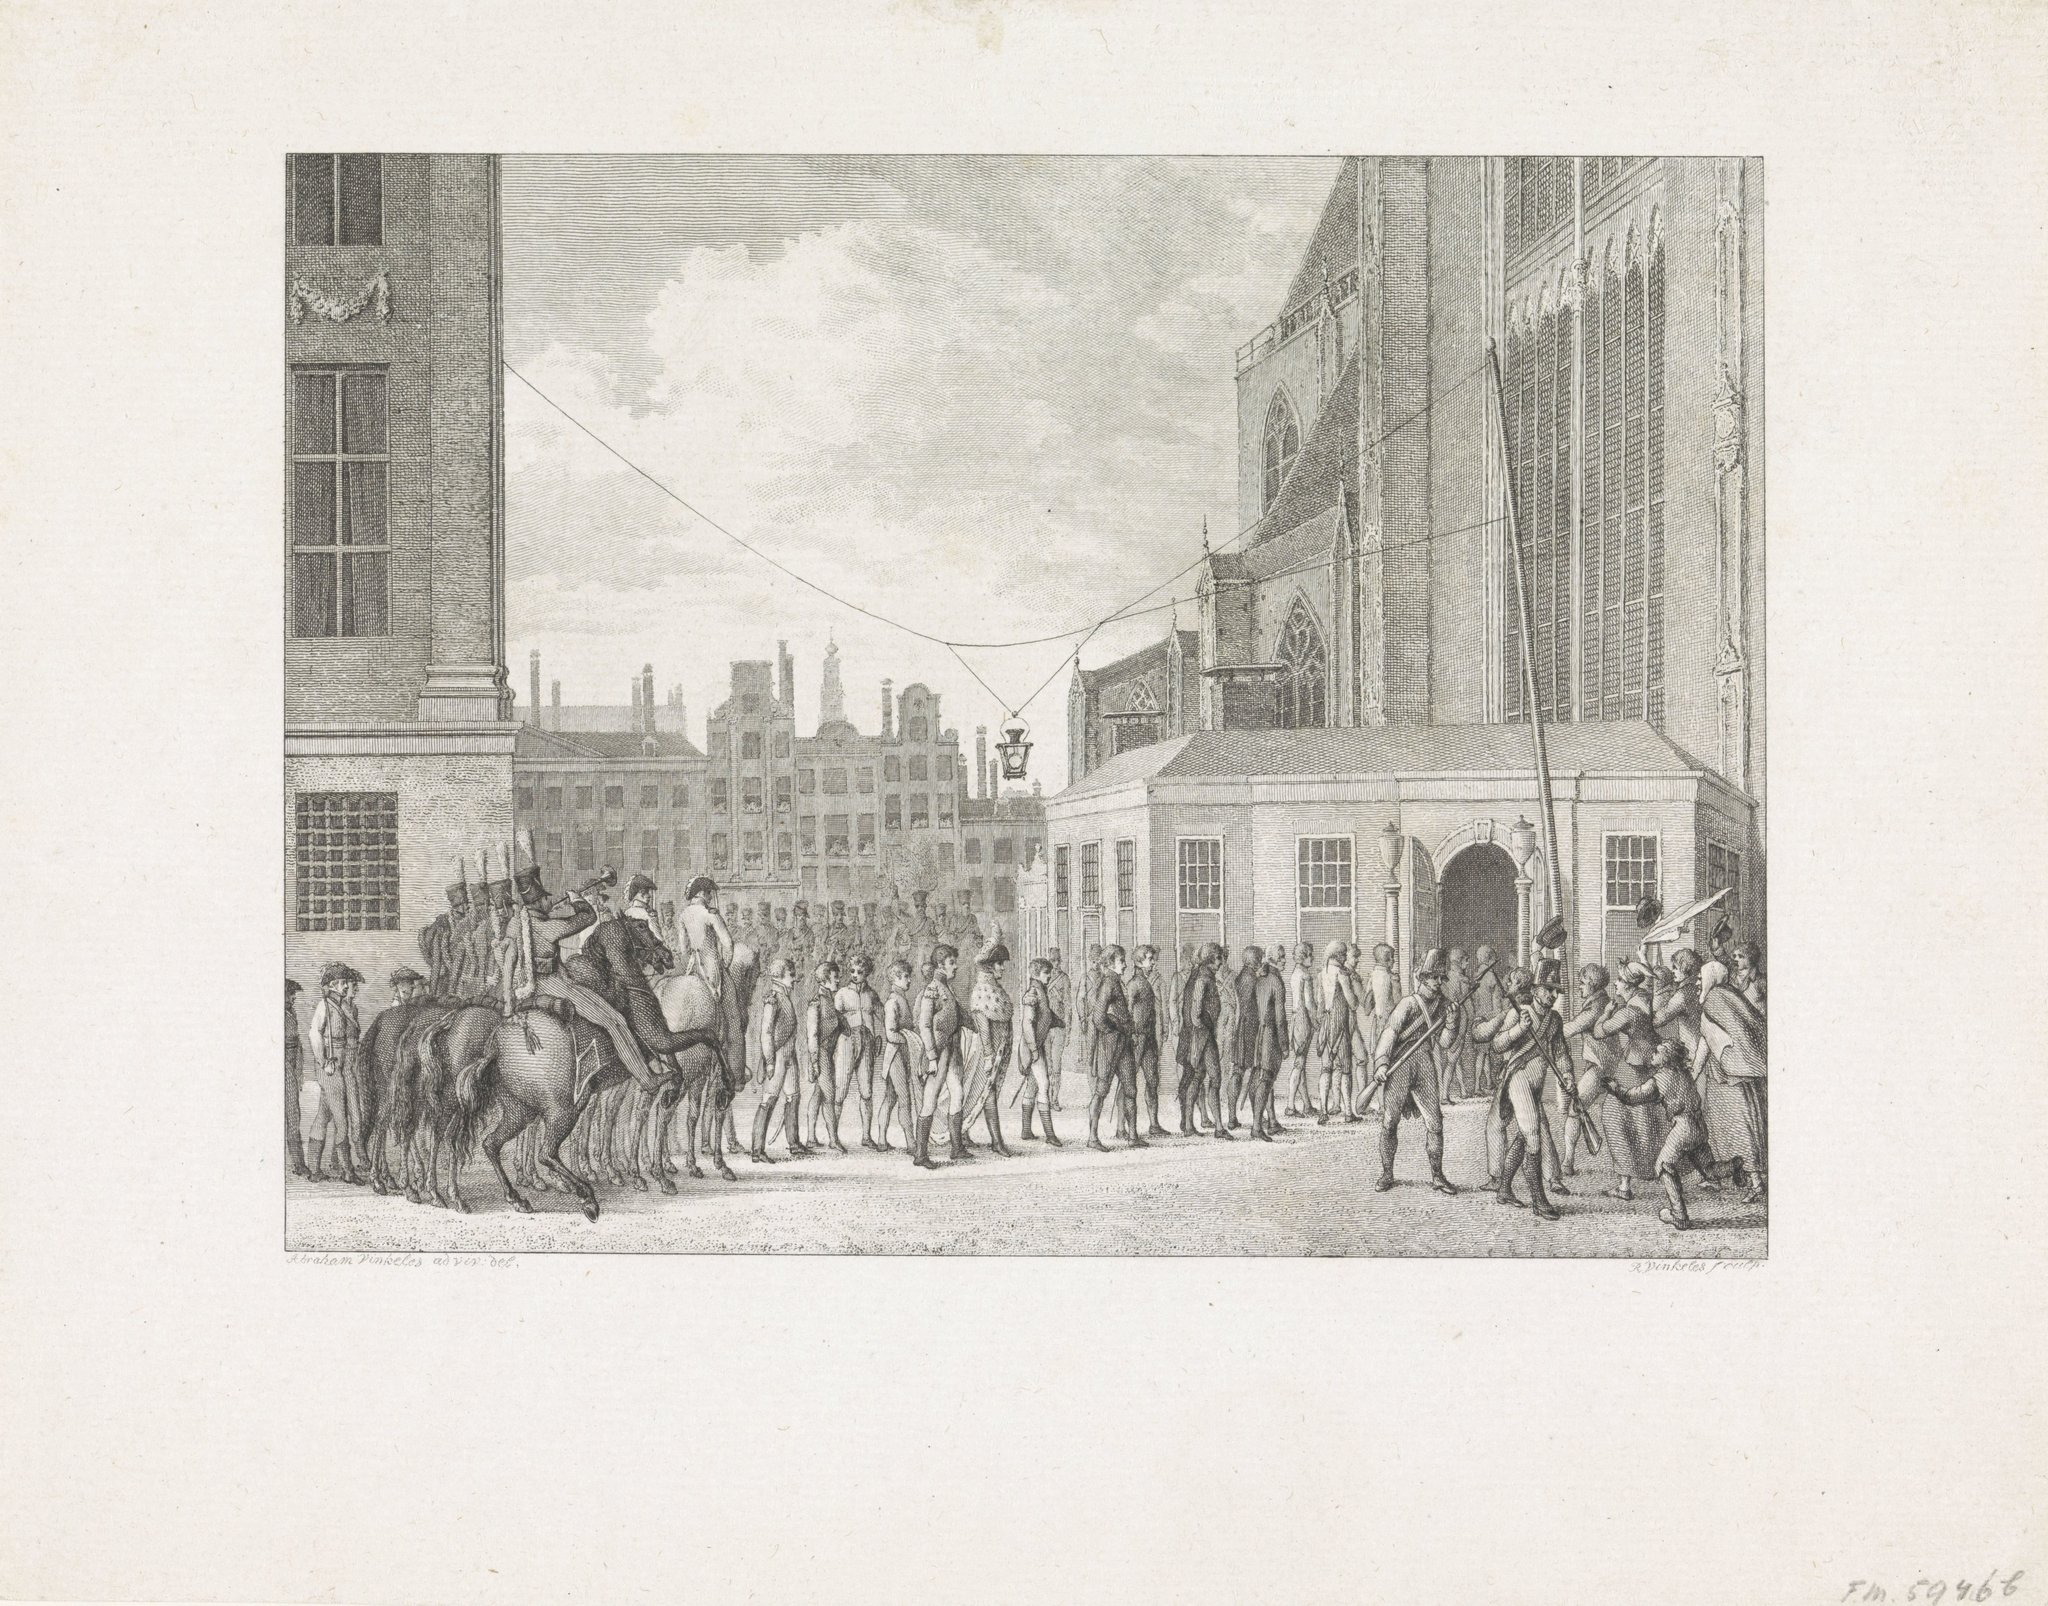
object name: print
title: Willem Frederik, prins van Oranje in de stoet van leden van de Vergadering der Aanzienlijken, 1814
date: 1814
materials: paper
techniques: engraving, etching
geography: netherlands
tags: the hague, berlin, william i of the netherlands, ceremonial celebration of installation of a ruler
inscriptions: collector's mark: Lugt 2228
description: Willem Frederik, prins van Oranje als souverein vorst sluit aan in de stoet van leden van de Vergadering der Aanzienlijken gaande van het Koninklijk Paleis naar de Nieuwe Kerk te Amsterdam op 29 maart 1814. Zie ook de pendant.